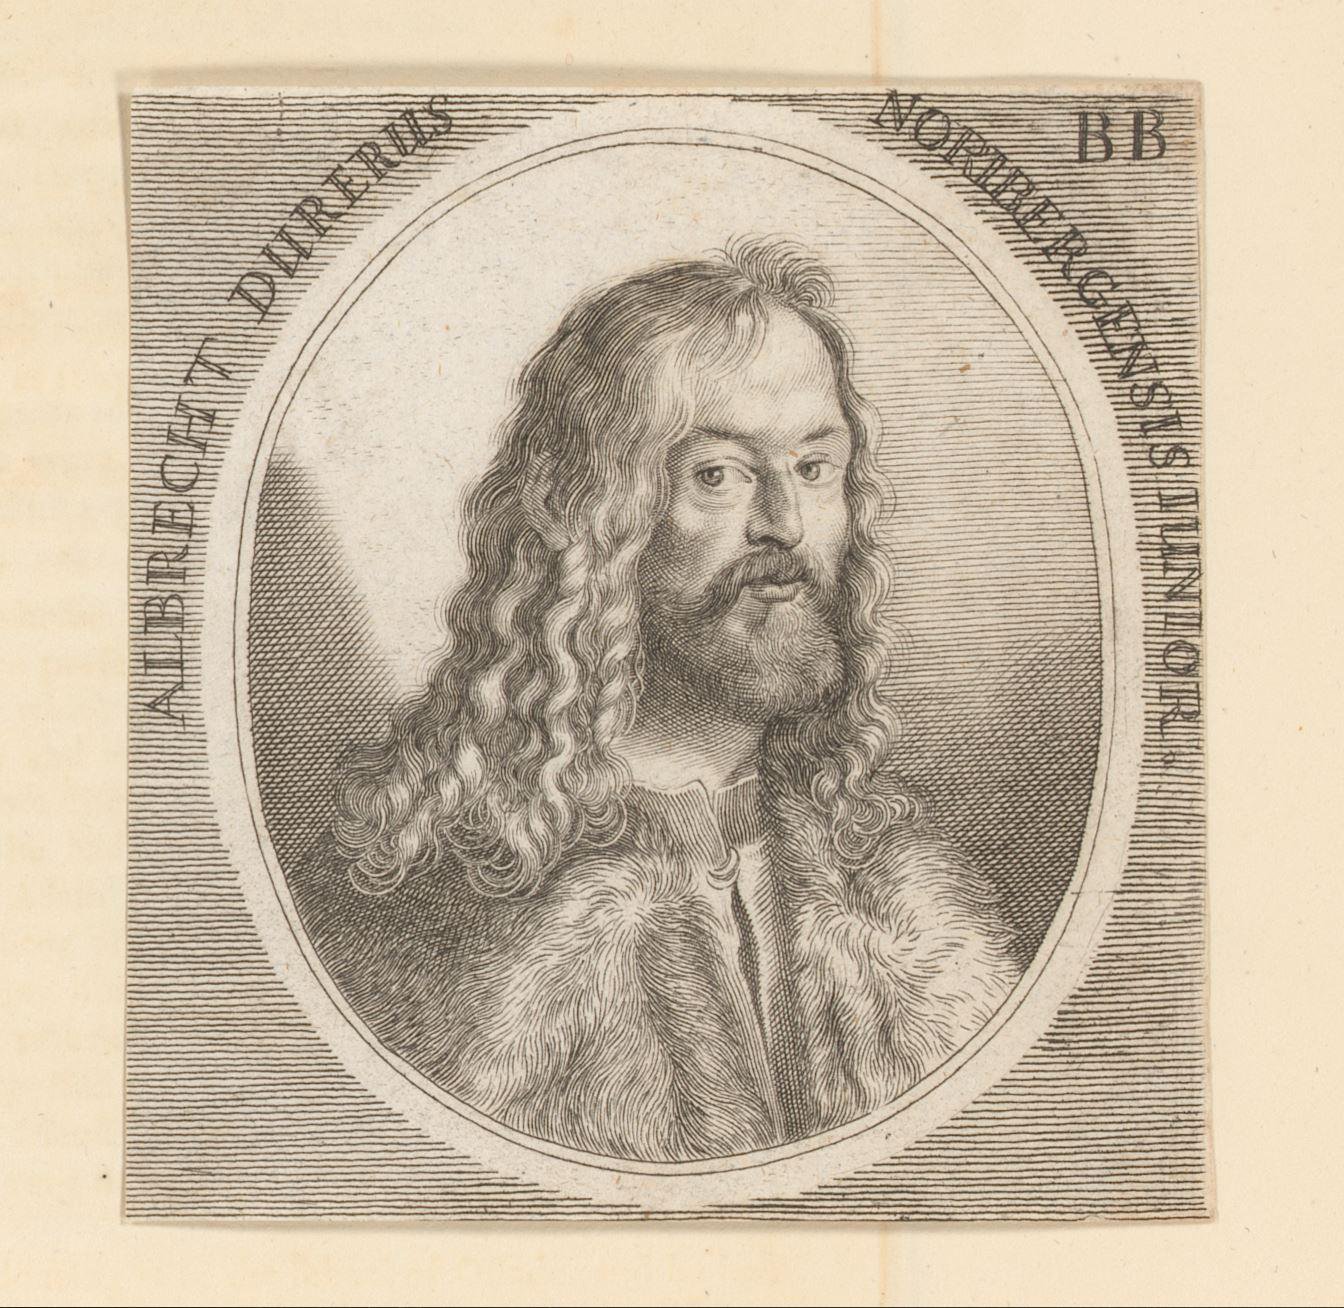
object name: book illustration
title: Portret van Albrecht Dürer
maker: philipp kilian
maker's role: print maker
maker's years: 1628-1693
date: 1768-1775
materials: paper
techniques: engraving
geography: nuremberg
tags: painter, draughtsman, albrecht dürer, historical persons, portrait, self-portrait of painter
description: Prent uit: Sandrart, Joachim von. Teutsche Academie der Bau- Bildhauer- und Maler-Kunst: worinn die Regeln und Lehrsätze dieser Künste gegeben. 14 dln. Neurenberg: erven Johann Andreas Endter, [1774], dl. 7, p. X. De samensteller heeft deze prent in het album geplakt als illustratie bij: Pilkington, Matthew en Johann Heinrich Füssli. A dictionary of painters, from the revival of the art to the present period. 4 dln. Londen: John Crowder, 1805, dl. 1, p. 168.